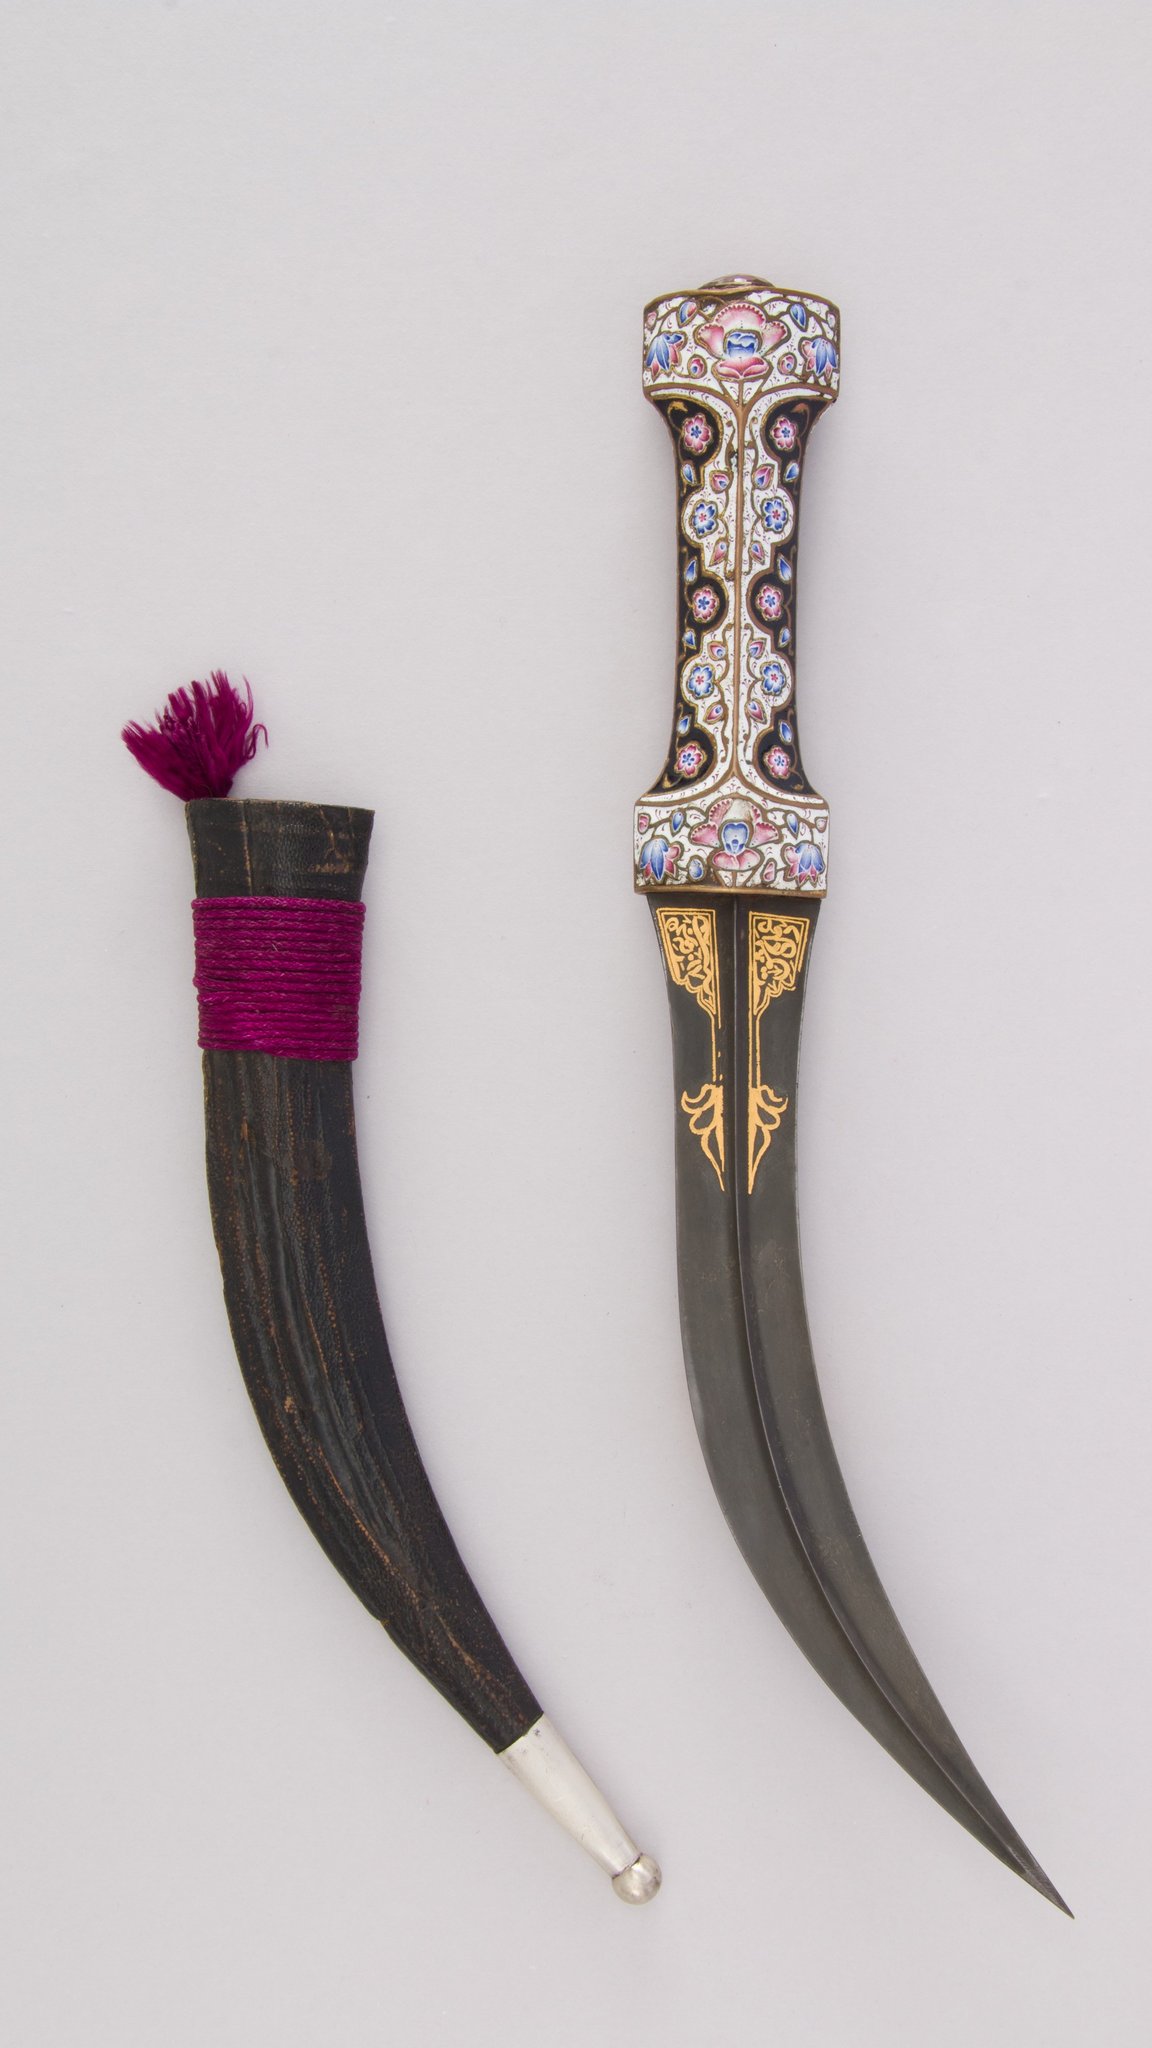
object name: dagger with sheath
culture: iranian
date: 1701-1800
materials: enamel, leather, silver, steel, stone, textile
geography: iran